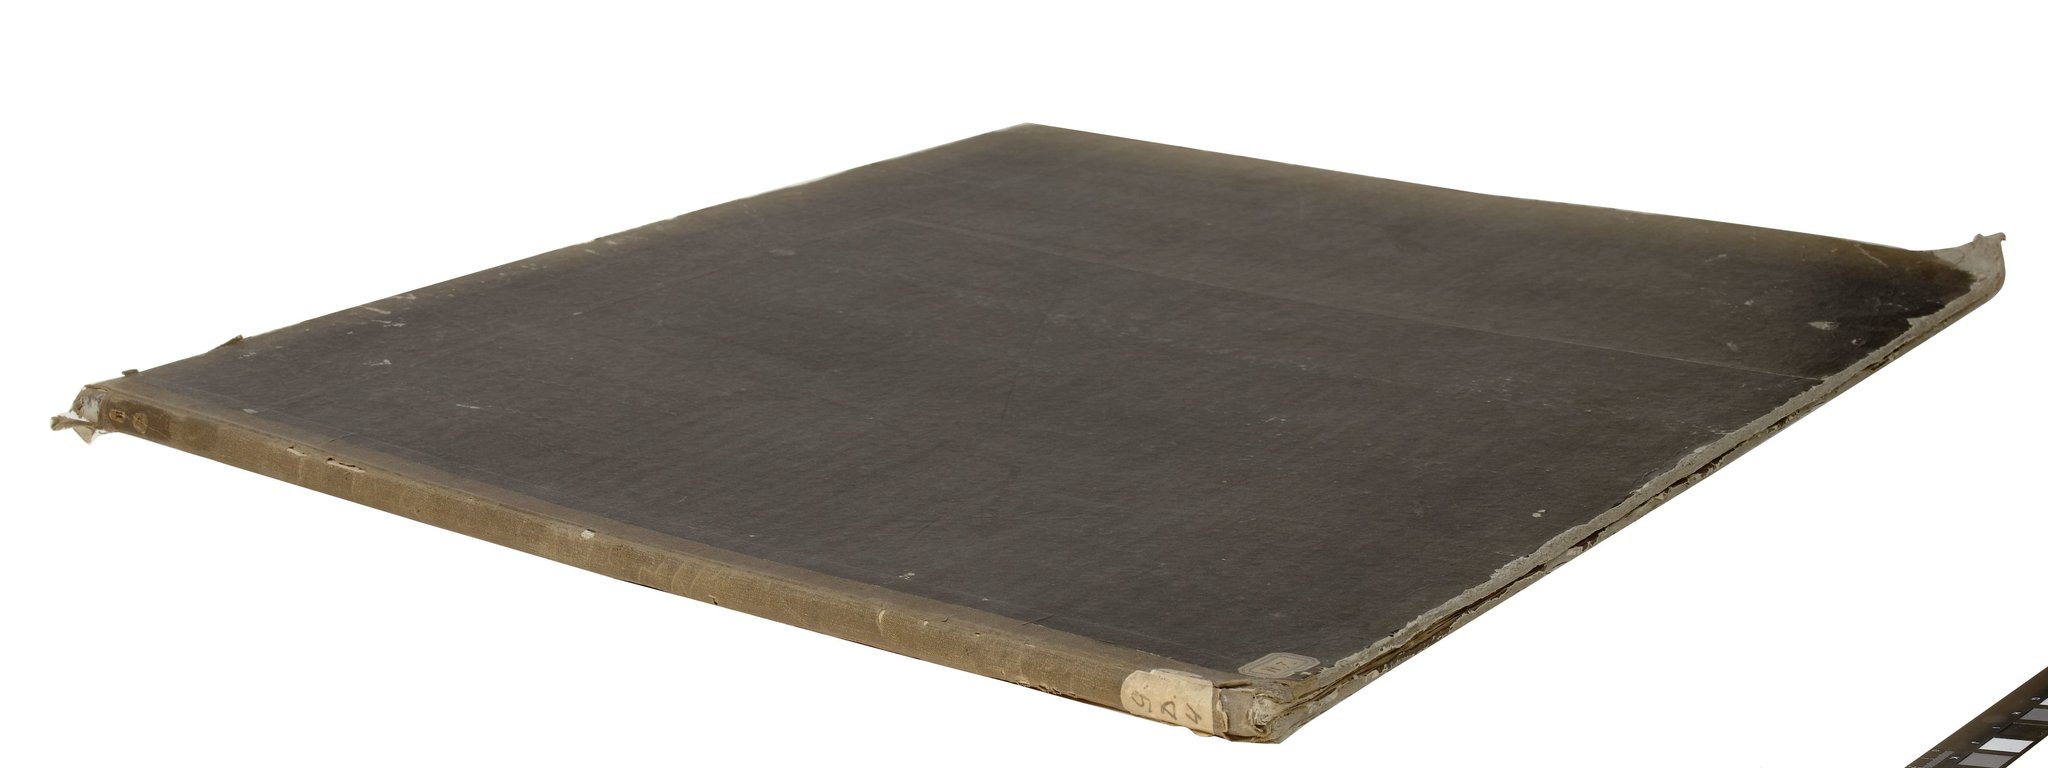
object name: album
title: Schouwburg van den Oorlog, Beginnende van Koning Karel den II. Tot op Koning Karel den III. Bestaande in IX. Historische Figuren op een Olifants Blad, als Veldslagen, Belegeringen te Water en te Lande, met de voornaamste Vestingen (...)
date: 1722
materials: cardboard, linen, paper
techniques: etching, letterpress printing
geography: amsterdam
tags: spaanse successieoorlog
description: Prentwerk met de gebundelde reeks van 31 platen en een titelpagina met voorstellingen (het merendeel verdeeld in 9 kleinere scènes) van gebeurtenissen uit de jaren 1700-1722 van de Spaanse Successieoorlog, kaarten en plattegronden. In een moderne band van karton bekleed met groen linnen. Volgens het titelblad de editie van 1720, het album is echter samengesteld ca. 1722.